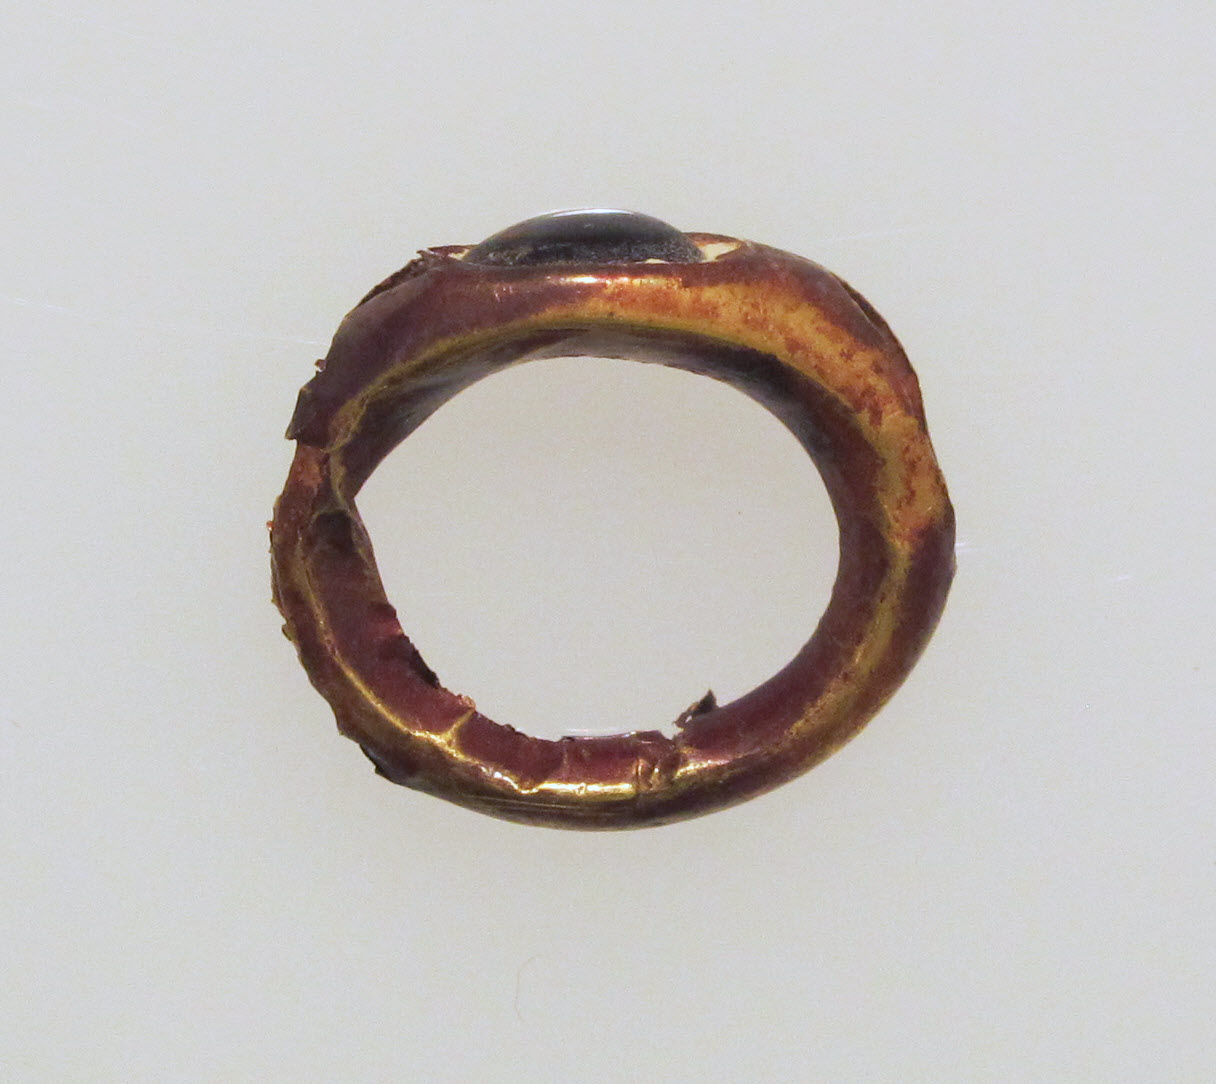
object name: ring with garnet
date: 7000 BCE-330 CE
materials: gemstone, gold